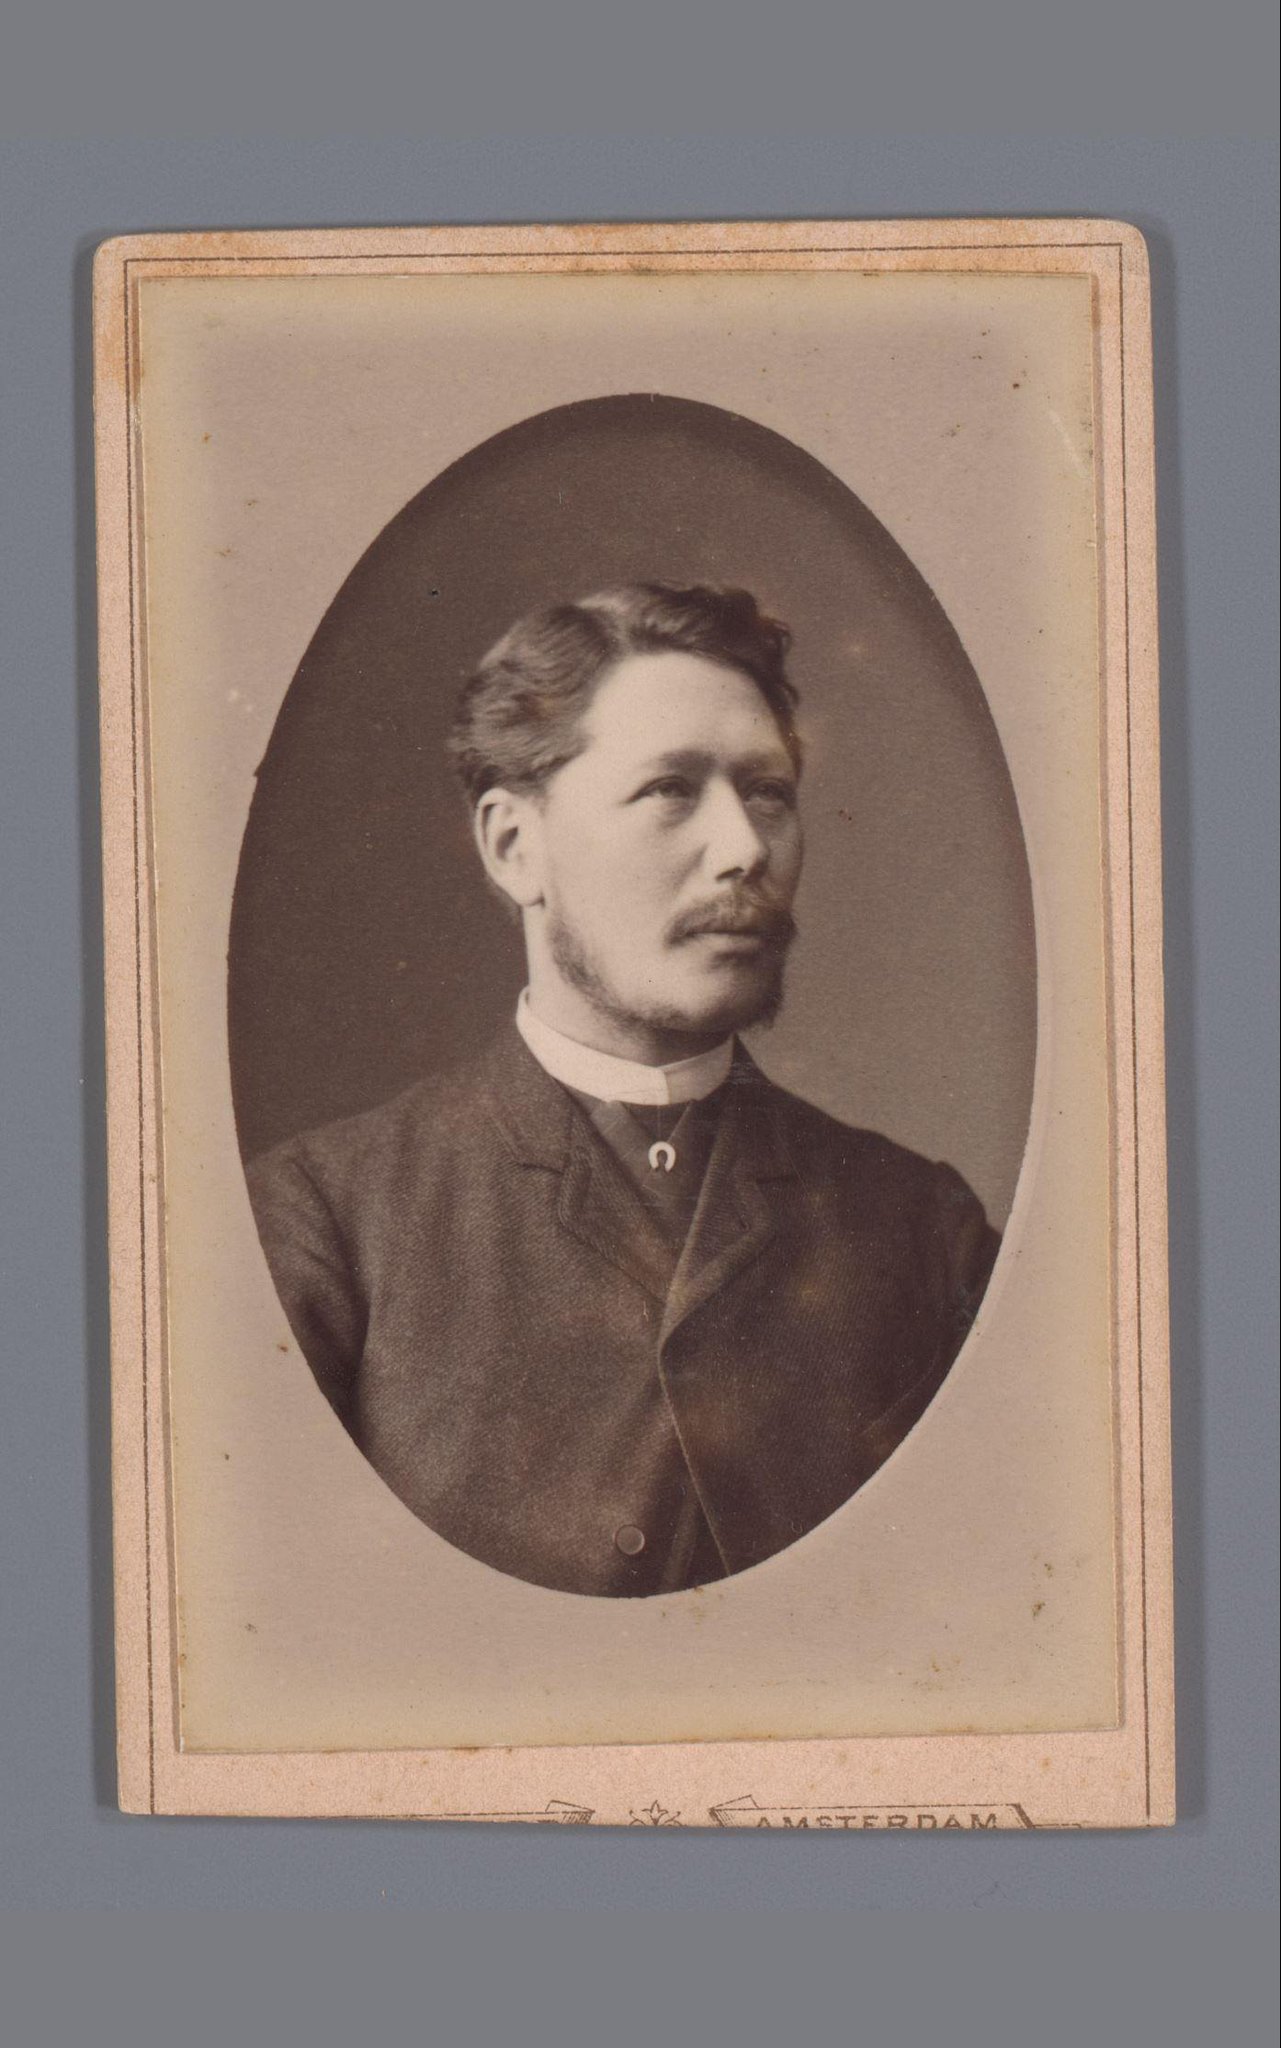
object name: carte de visite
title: Portret van een onbekende man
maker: willem gerhardus kuijer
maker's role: fotograaf, hoffotograaf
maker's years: 1834-1899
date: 1862-1899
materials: cardboard, photographic support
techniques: collodion silver print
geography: amsterdam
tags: historical persons, amsterdam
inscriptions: workshop stamp: ‘W.G. Kuijer/ Amsterdam, Westermarkt 19’